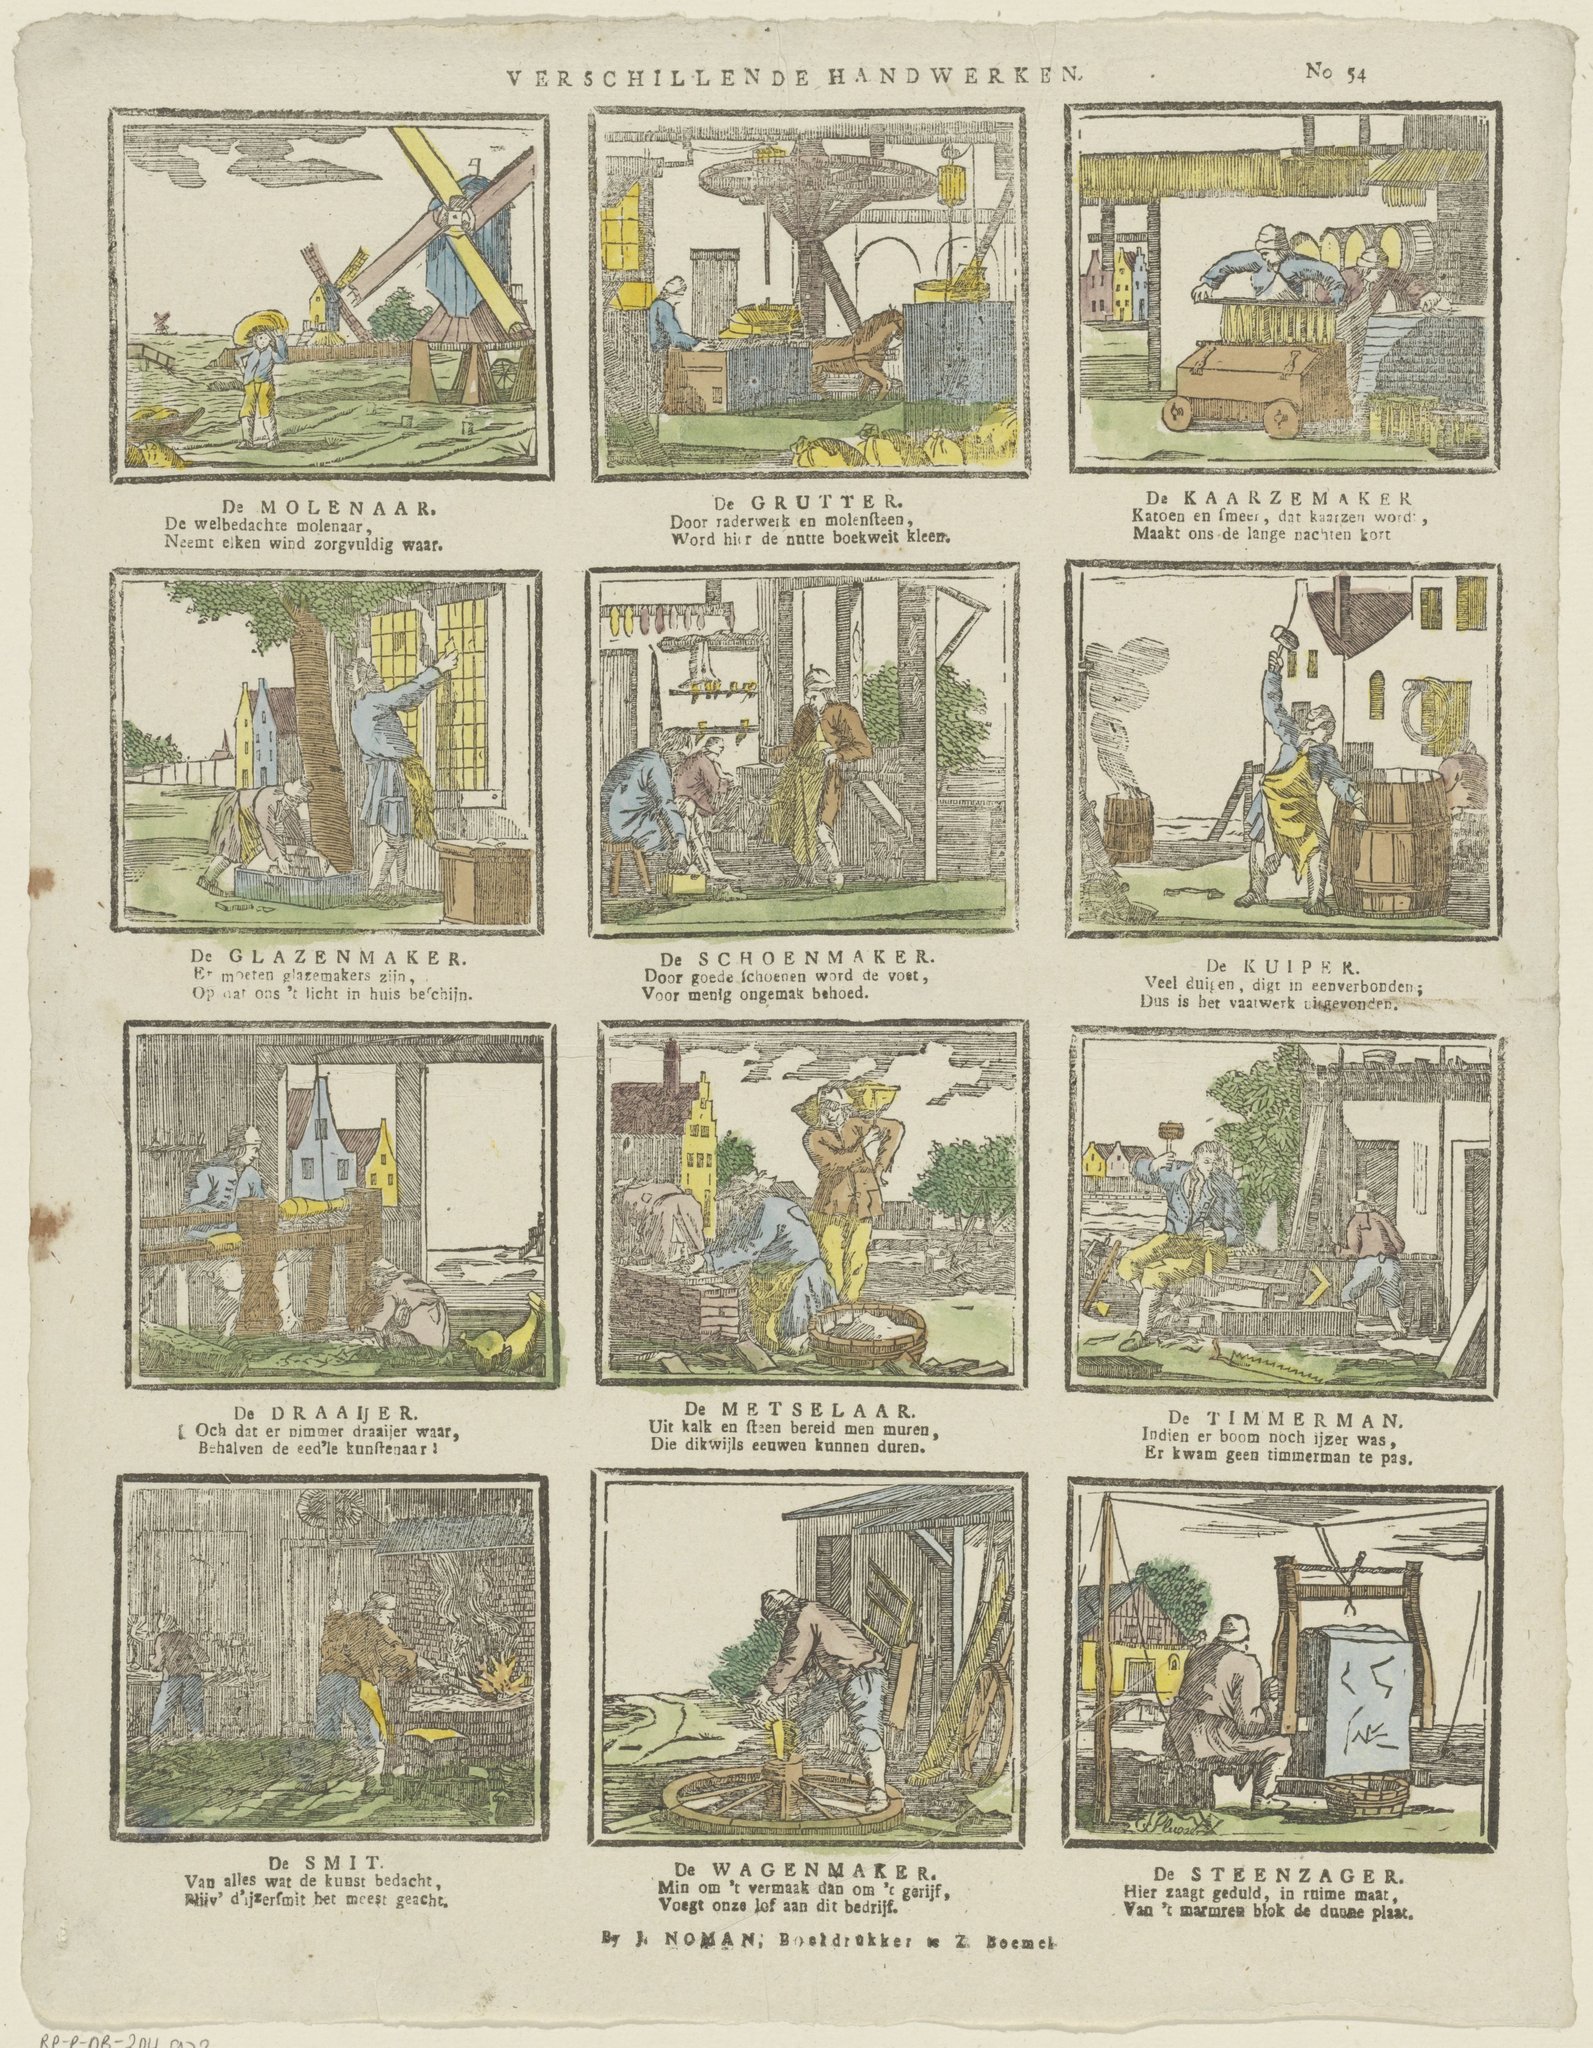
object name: print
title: Verschillende handwerken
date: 1806-1830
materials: paper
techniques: colour, letterpress printing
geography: zaltbommel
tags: craft-production, skilled handiwork, miller, working class, labourers, smith, blacksmith, mason at work, crafts and industries, shoe-maker, cobbler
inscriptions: collector's mark: Lugt 2760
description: Blad met 12 voorstellingen van ambachtslieden en beroepen, zoals molenaar, kaarsenmaker en schoenmaker. Onder elke afbeelding een titel en een tweeregelig vers. Genummerd rechtsboven: No 54.